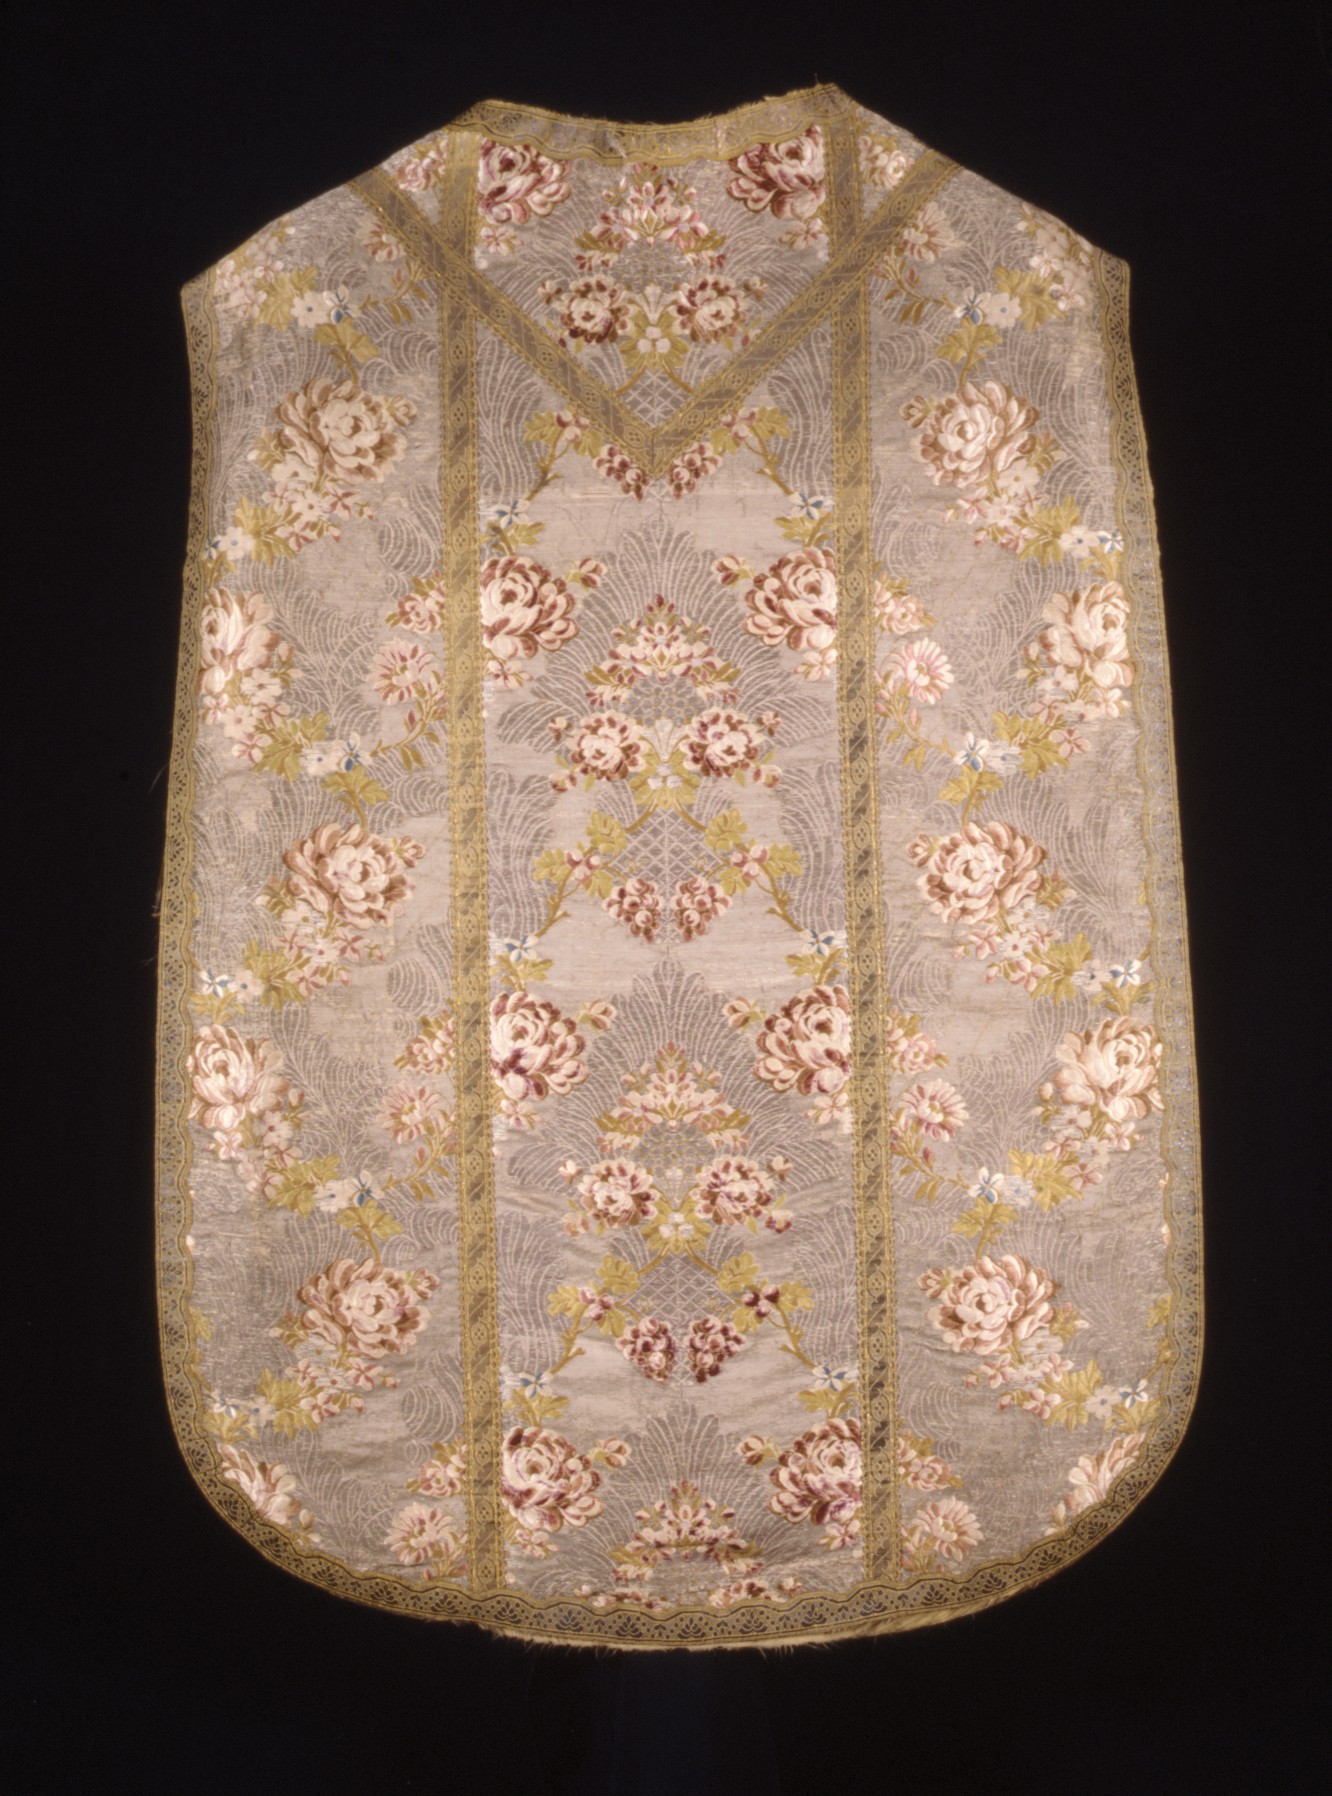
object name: chasuble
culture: french or italian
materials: cotton, linen, metal, silk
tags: flowers